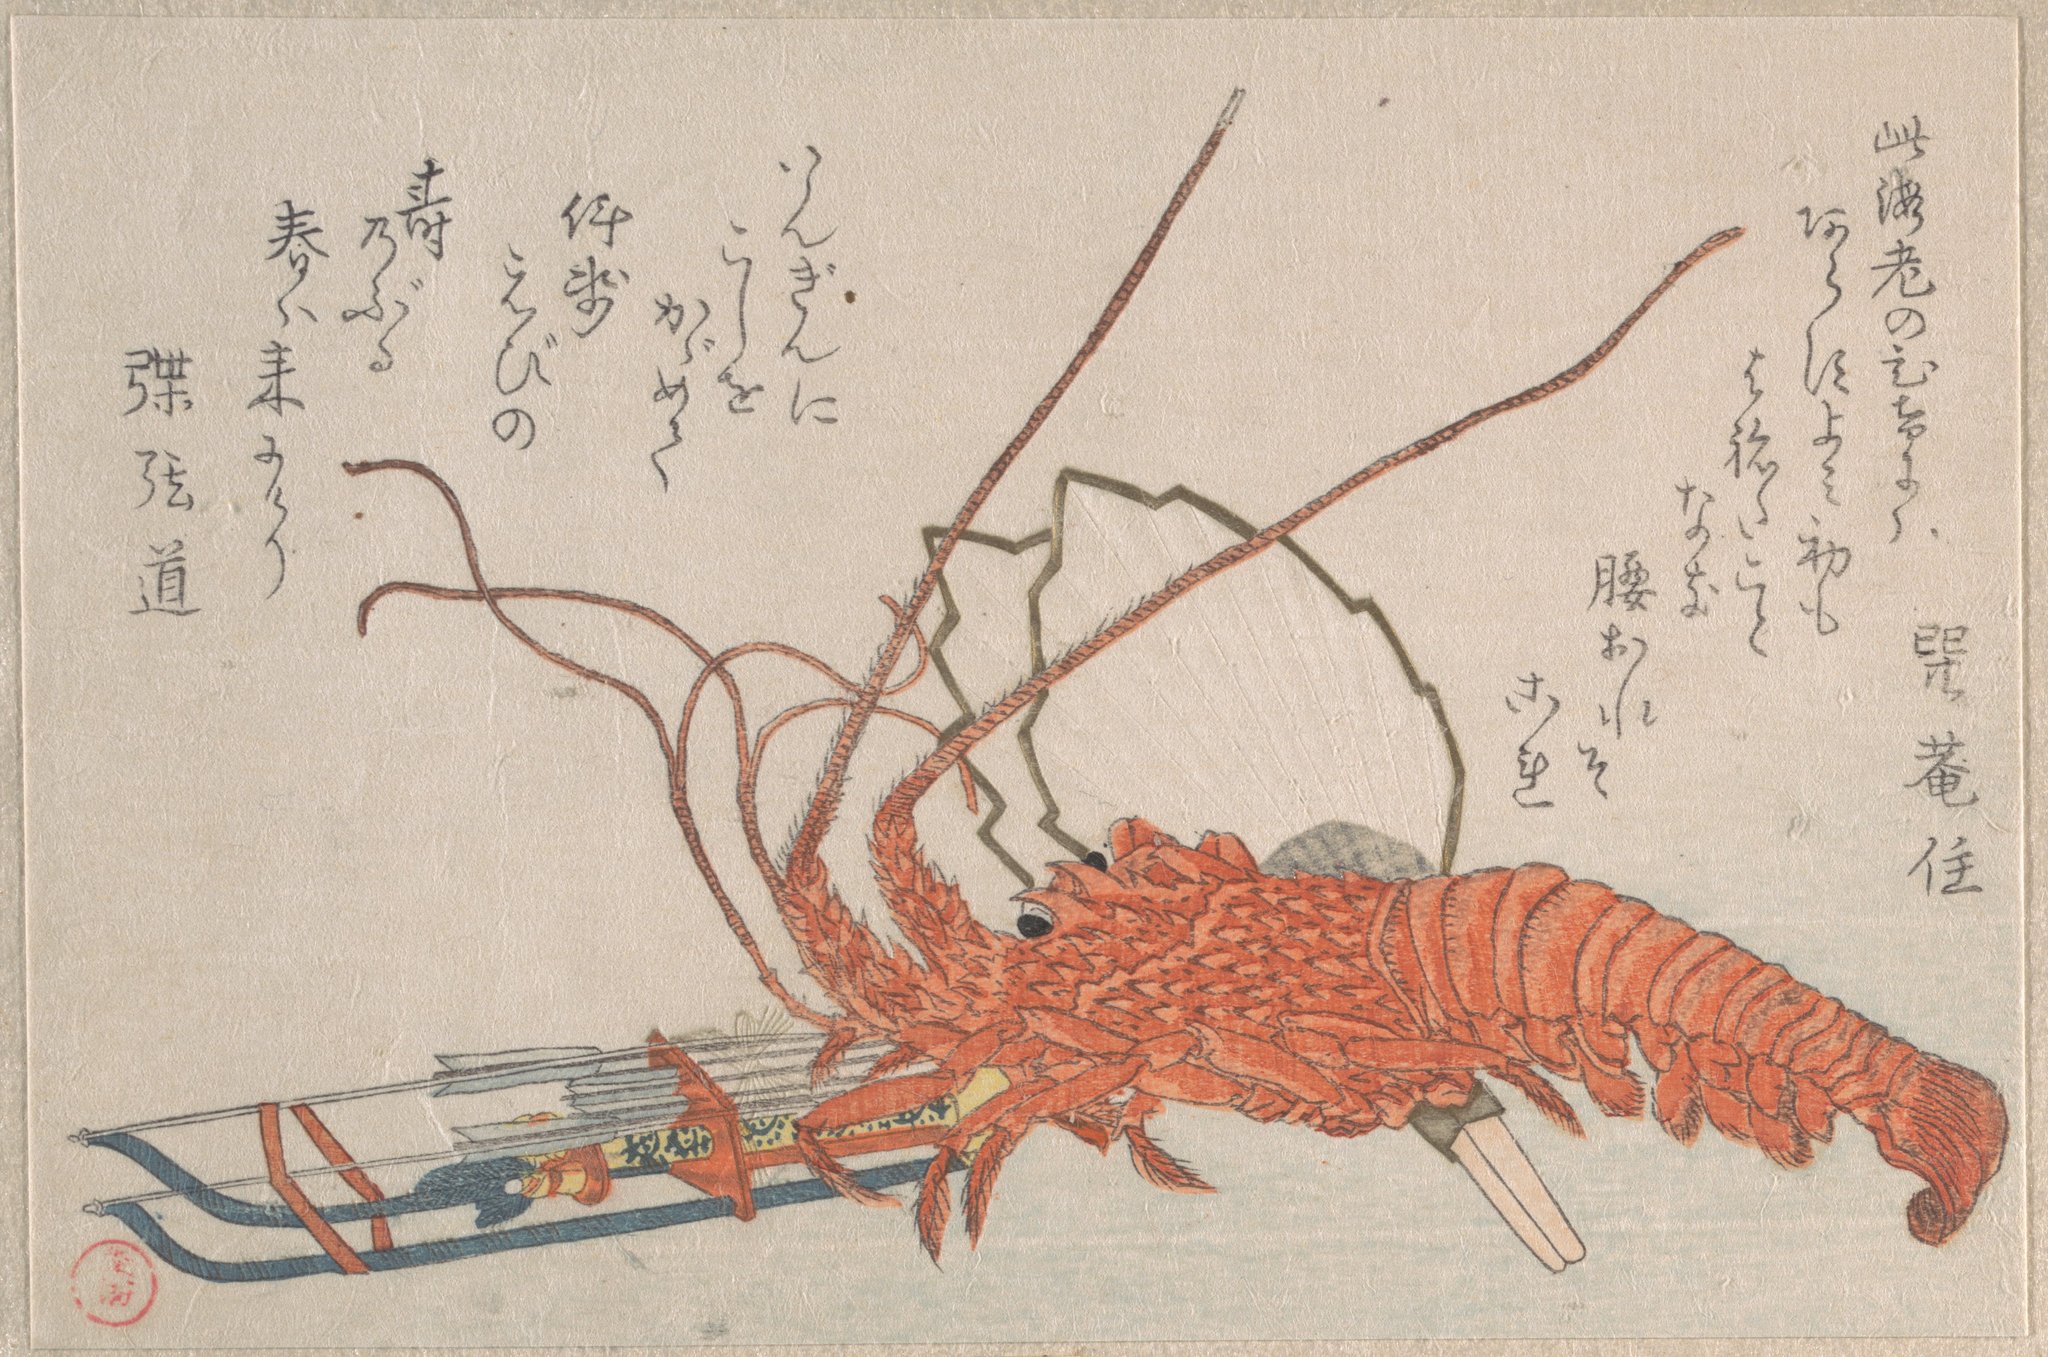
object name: print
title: Lobster, Hamayumi (Ceremonial Miniature Bow) with Arrows and Fans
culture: japanese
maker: kubo shunman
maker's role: artist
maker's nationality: japanese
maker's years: 1757-1820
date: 1701-1900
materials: ink, paper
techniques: surimono, woodblock print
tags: lobsters